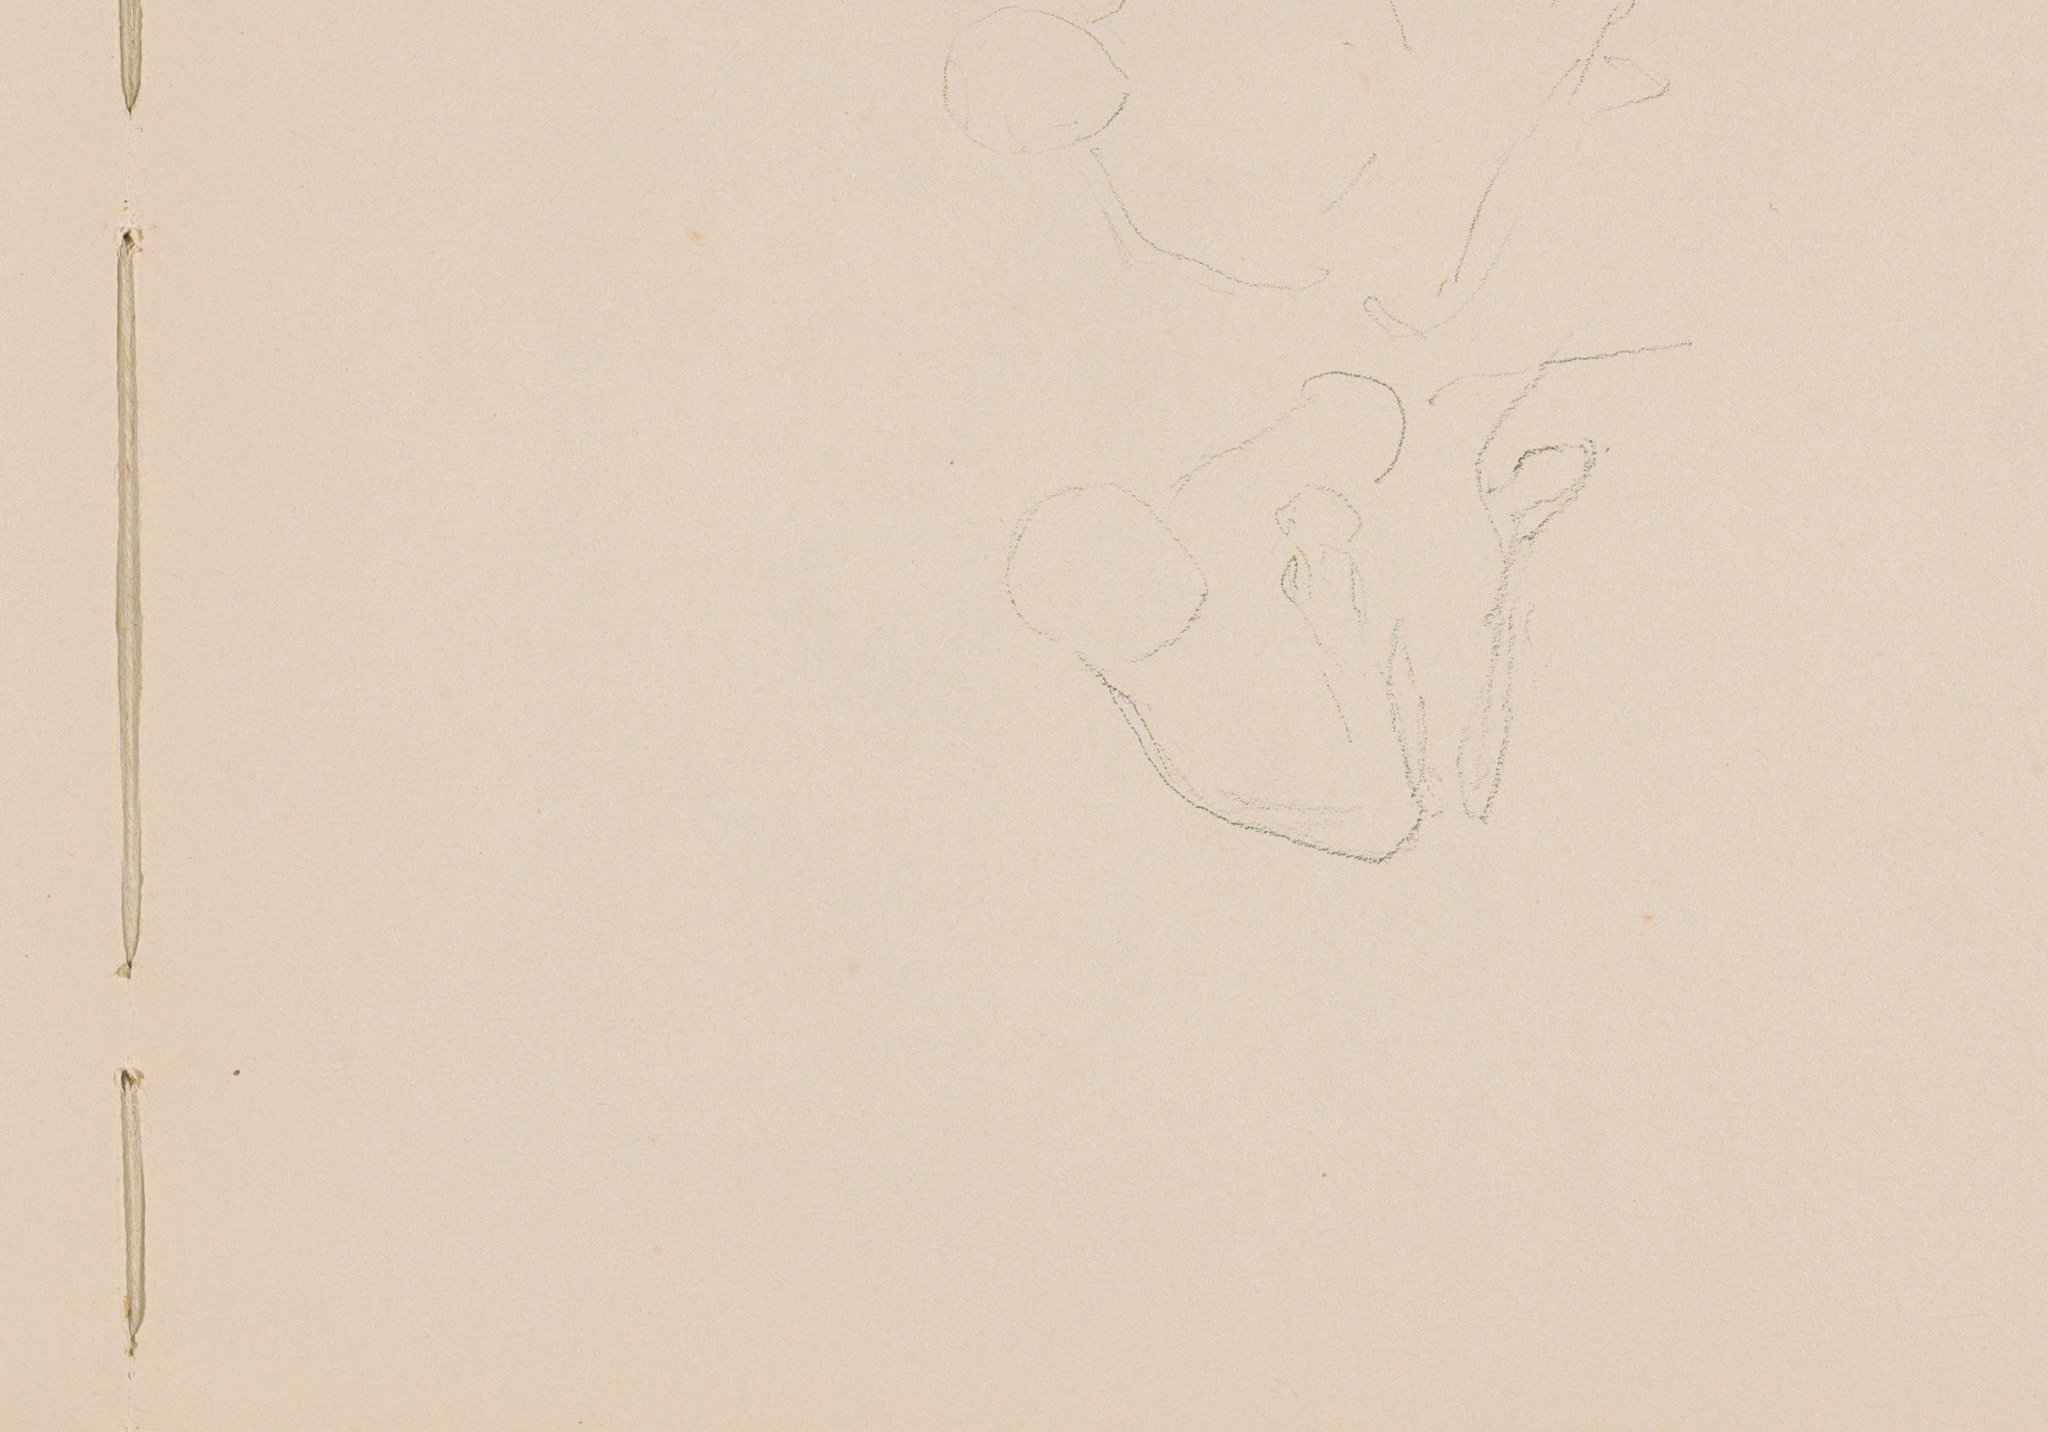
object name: sketchbook leaf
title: Twee zittende figuren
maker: a.a.l. de grammont-hubrecht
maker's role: draughtsman, painter, print maker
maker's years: 1855-1913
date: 1865-1913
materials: chalk, paper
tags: sitting figure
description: Eén van de figuren is vermoedelijk aan het handwerken. Blad 30 recto uit een schetsboek met 68 bladen.